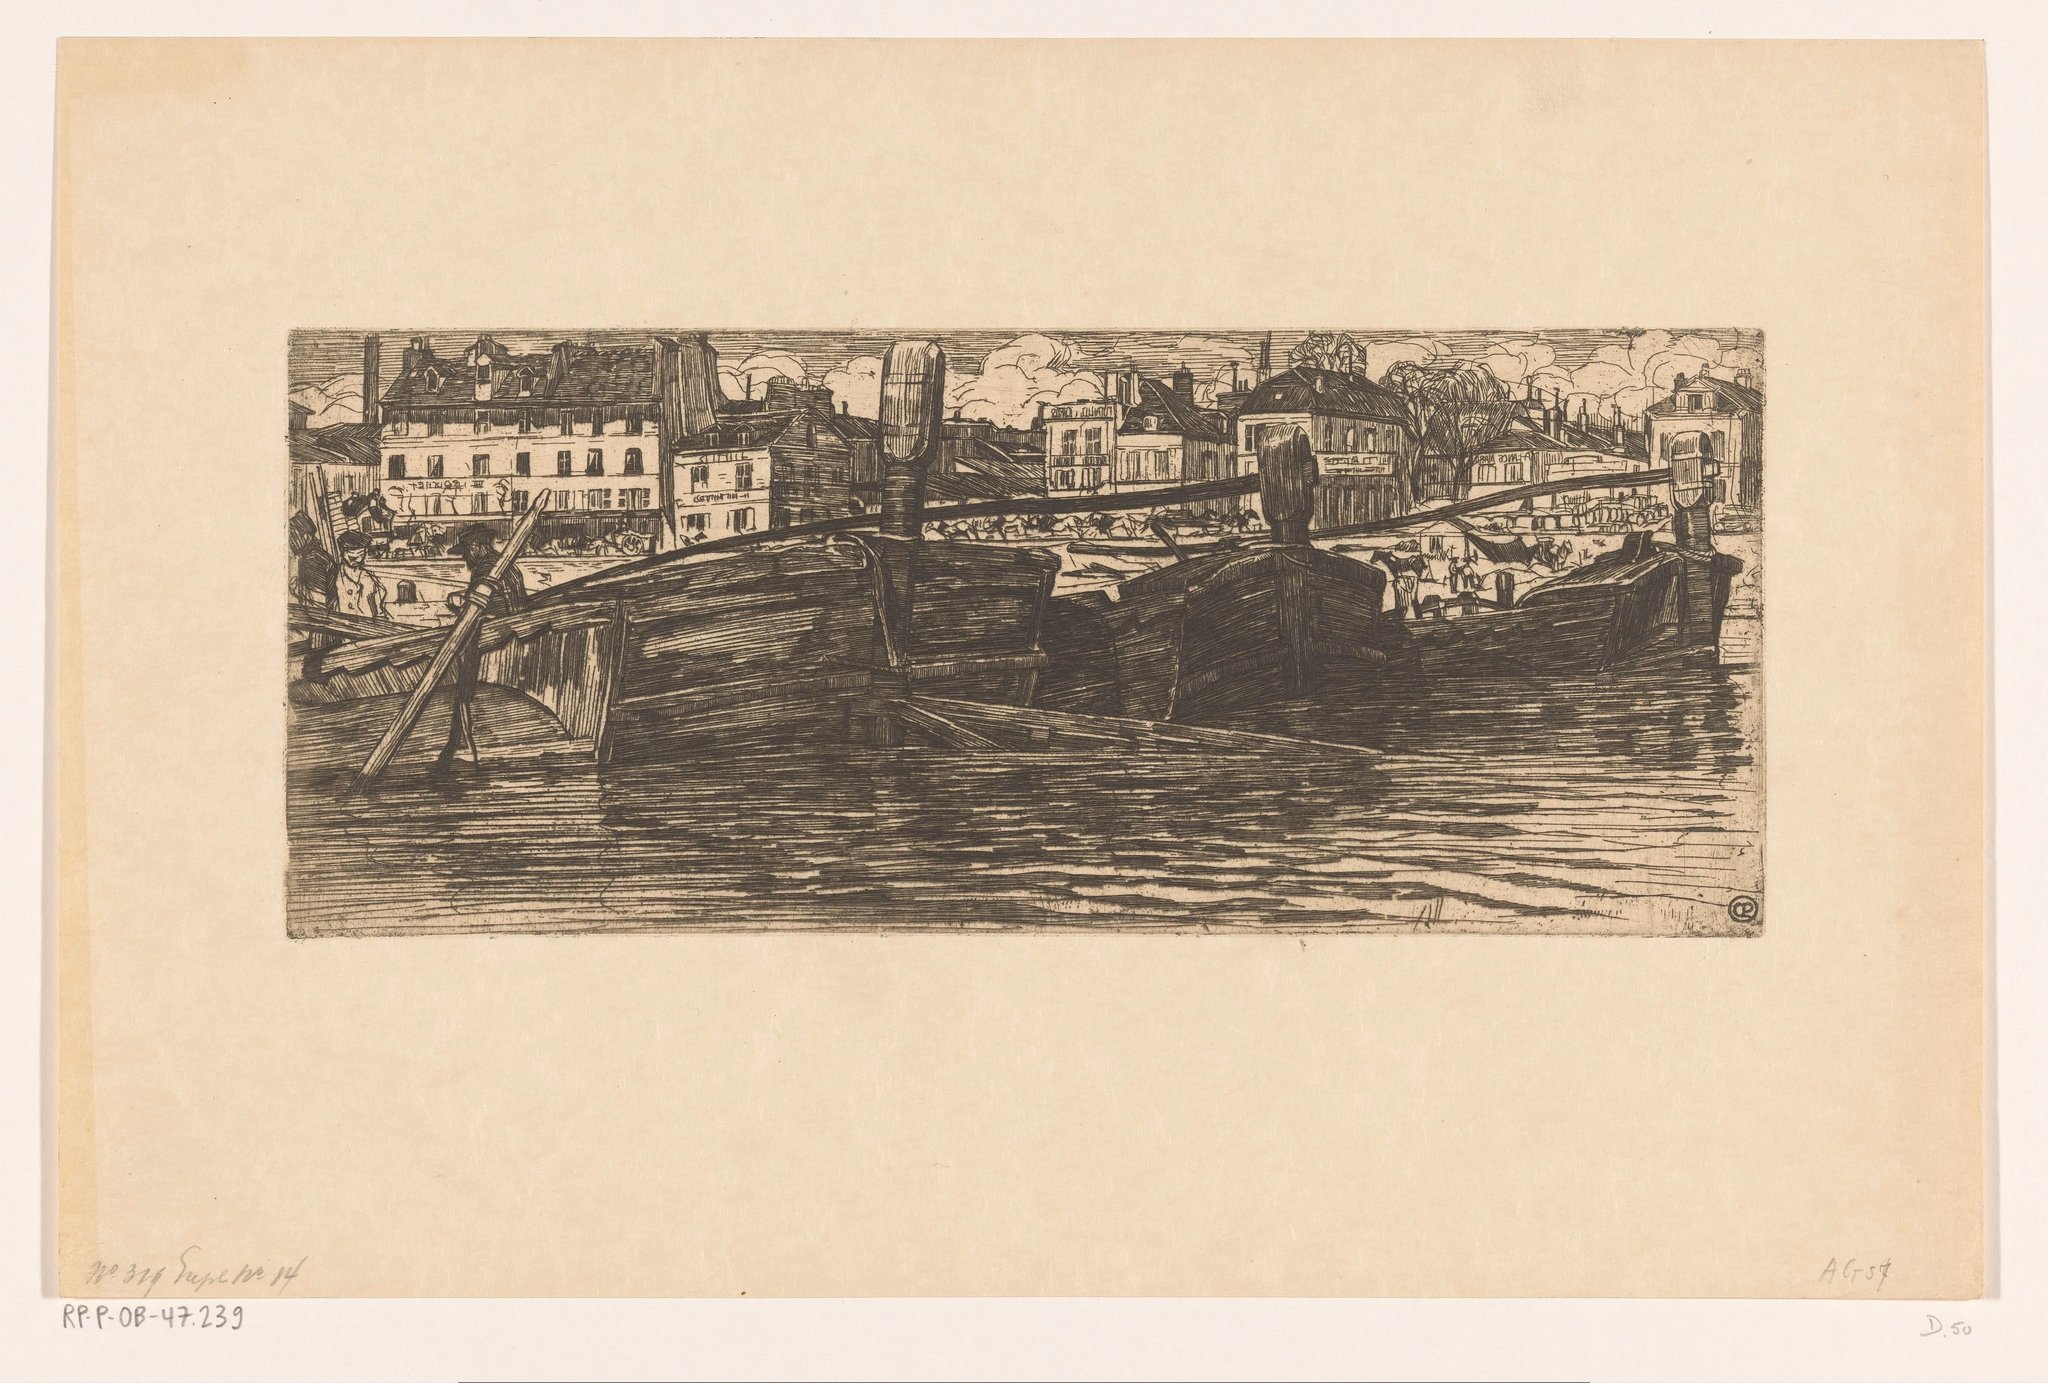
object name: print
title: Schuiten in de Seine in Parijs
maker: pieter dupont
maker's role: draughtsman, print maker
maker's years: 1870-1911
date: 1896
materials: paper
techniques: intaglio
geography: paris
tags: city-view, and landscape with man-made constructions, ships (in general), paris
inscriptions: collector's mark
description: Op de achtergrond huizen. Voor de huizen meerdere paarden, waarvan sommigen voor een rijtuig gespannen.